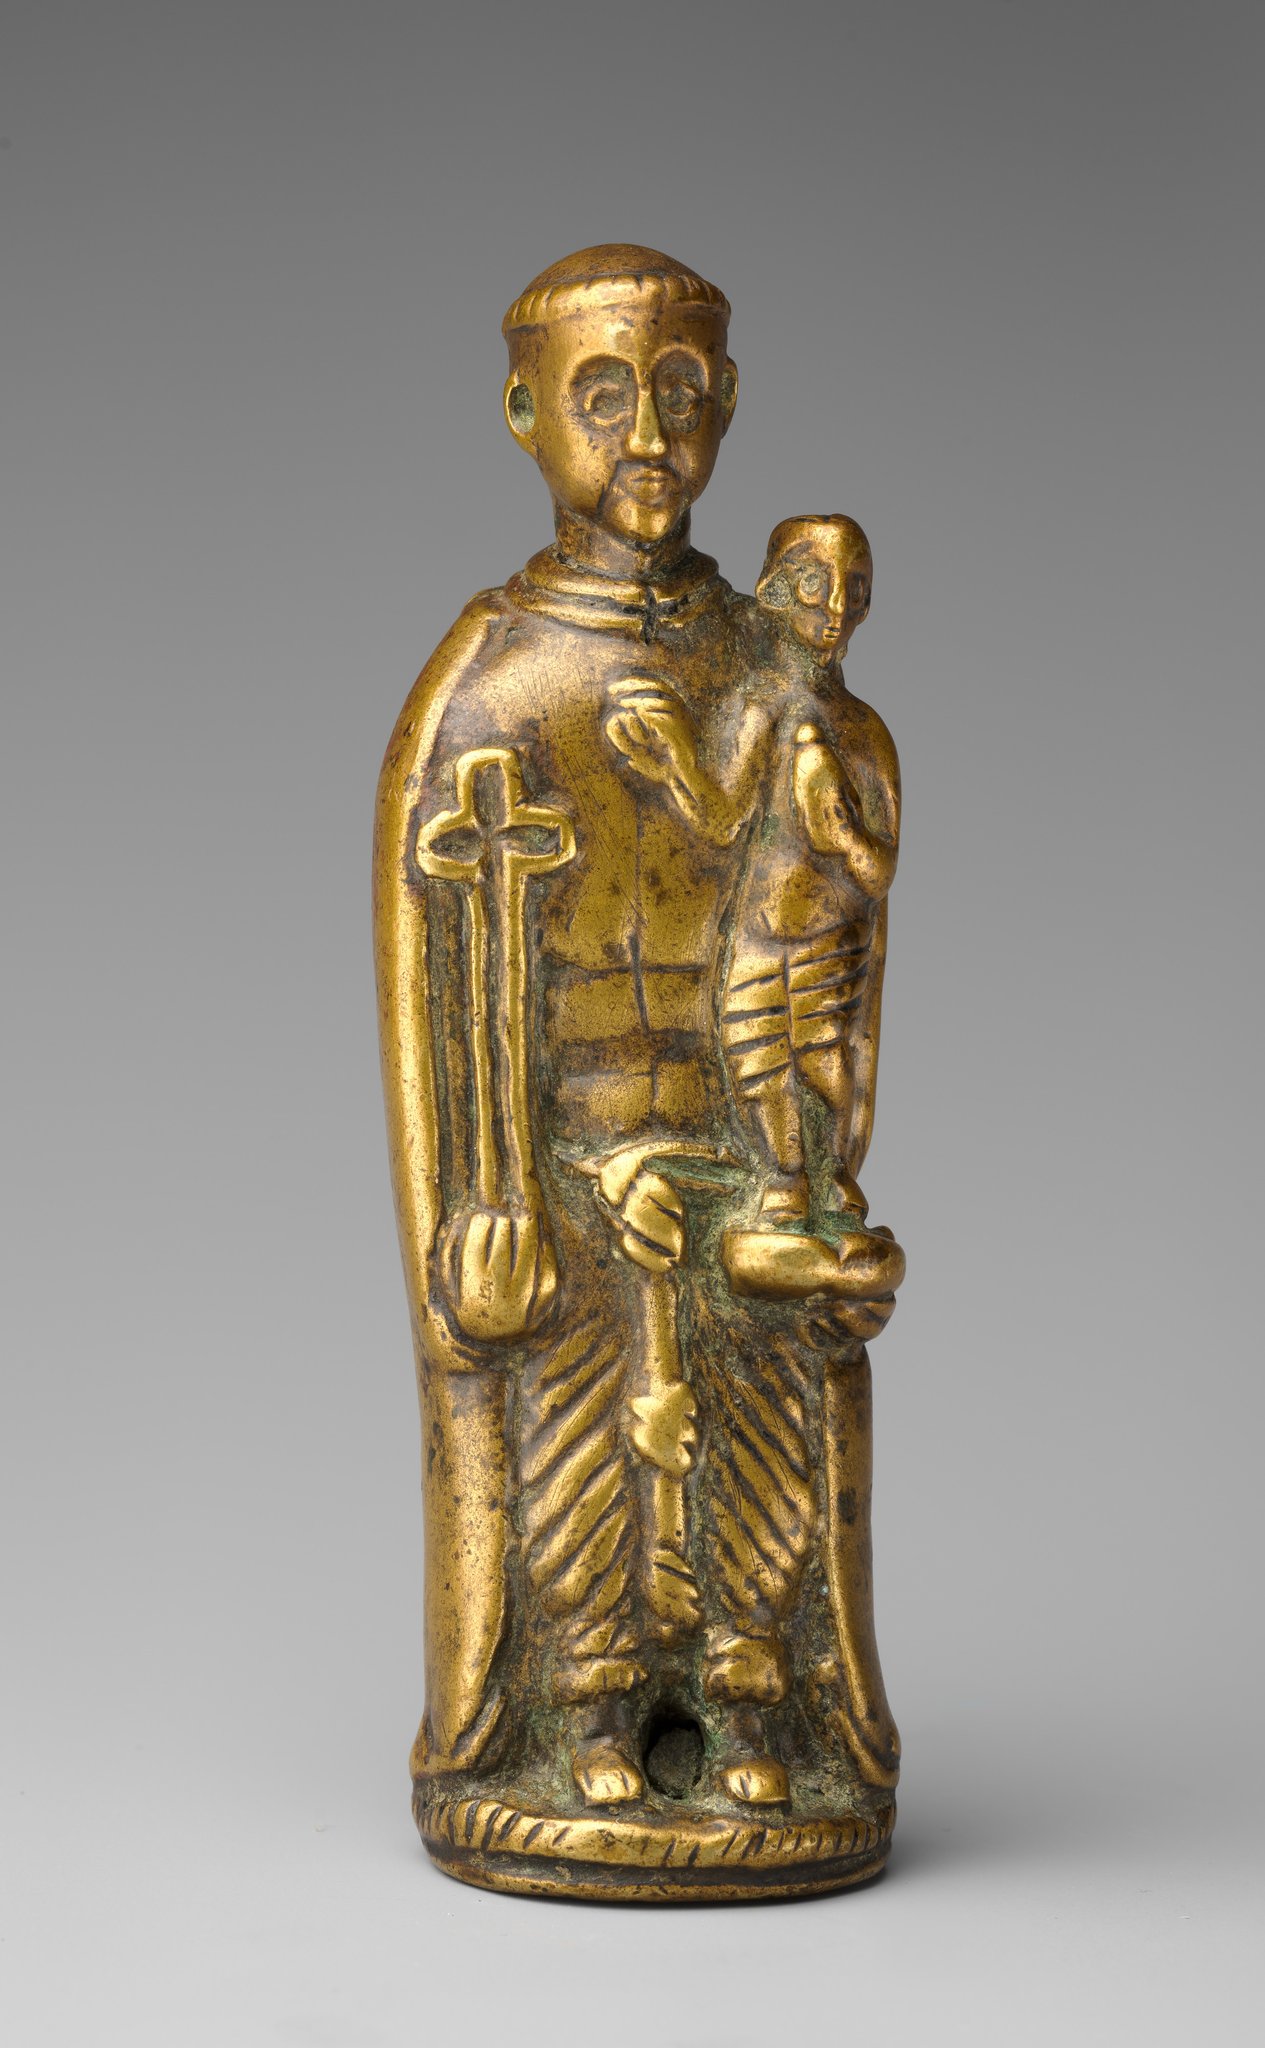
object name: pendant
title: Pendant with Saint Anthony of Padua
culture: kongo, kongo kingdom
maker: kongo artist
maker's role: artist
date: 1501-1900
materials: brass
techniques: casting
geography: angola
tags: men,christ,saint anthony,cross